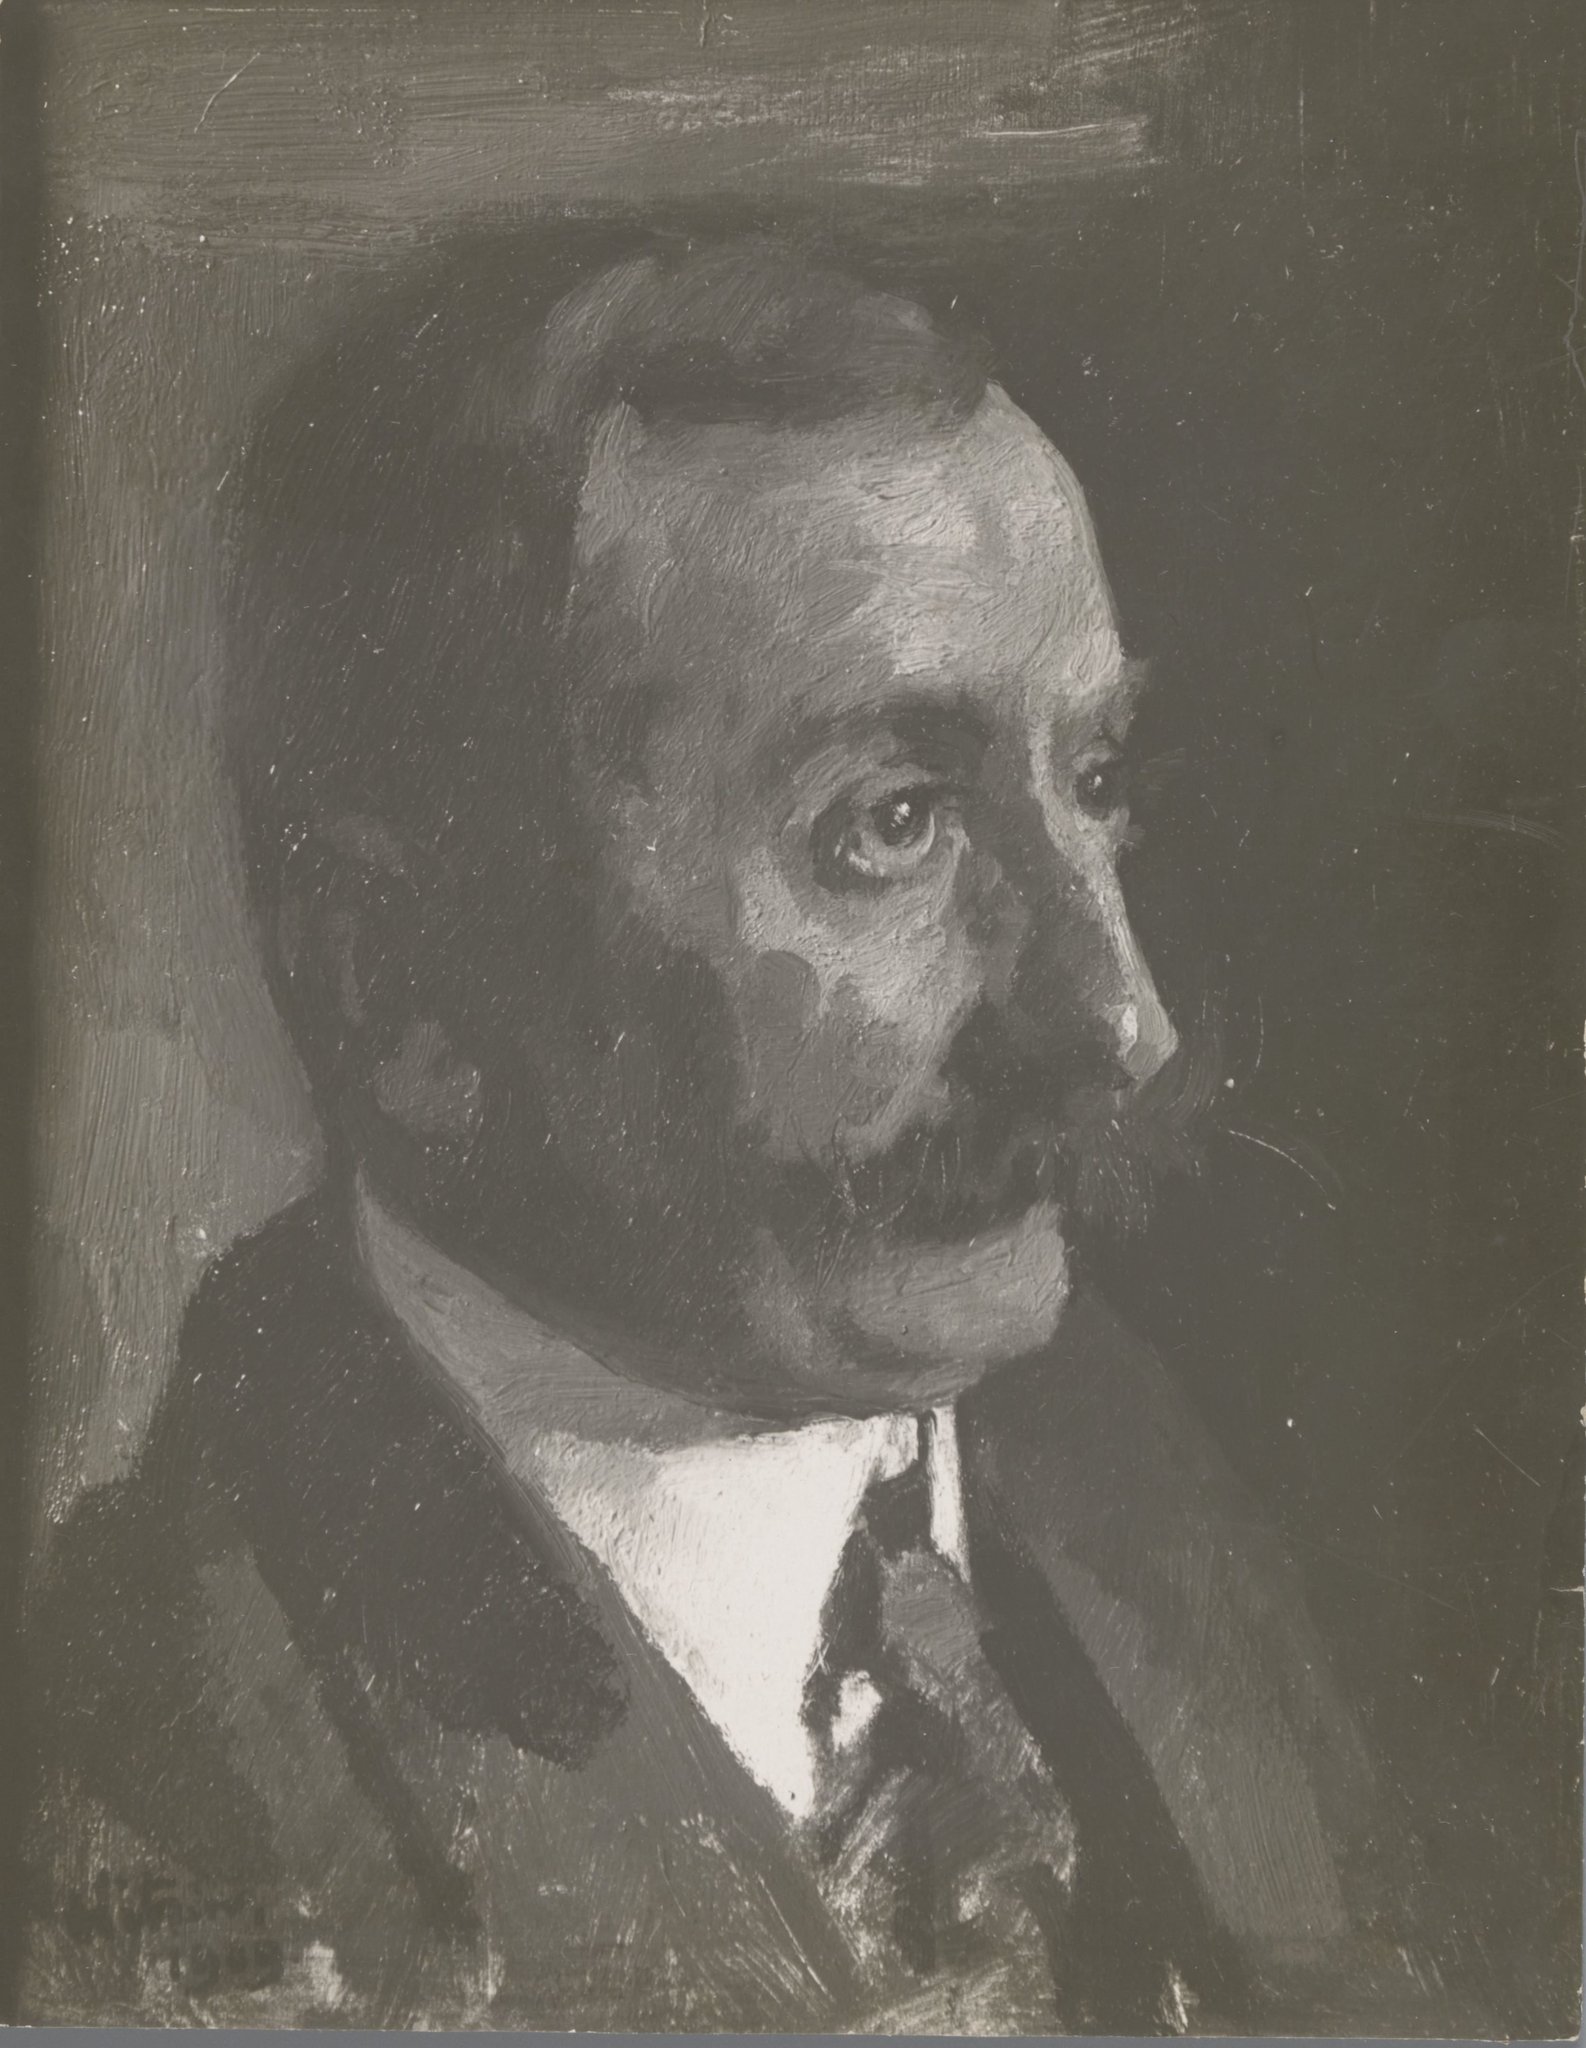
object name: photograph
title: Reproductie naar een foto, schilderij, tekening of prent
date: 1860-1915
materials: paper, photographic support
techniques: gelatin silver print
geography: netherlands